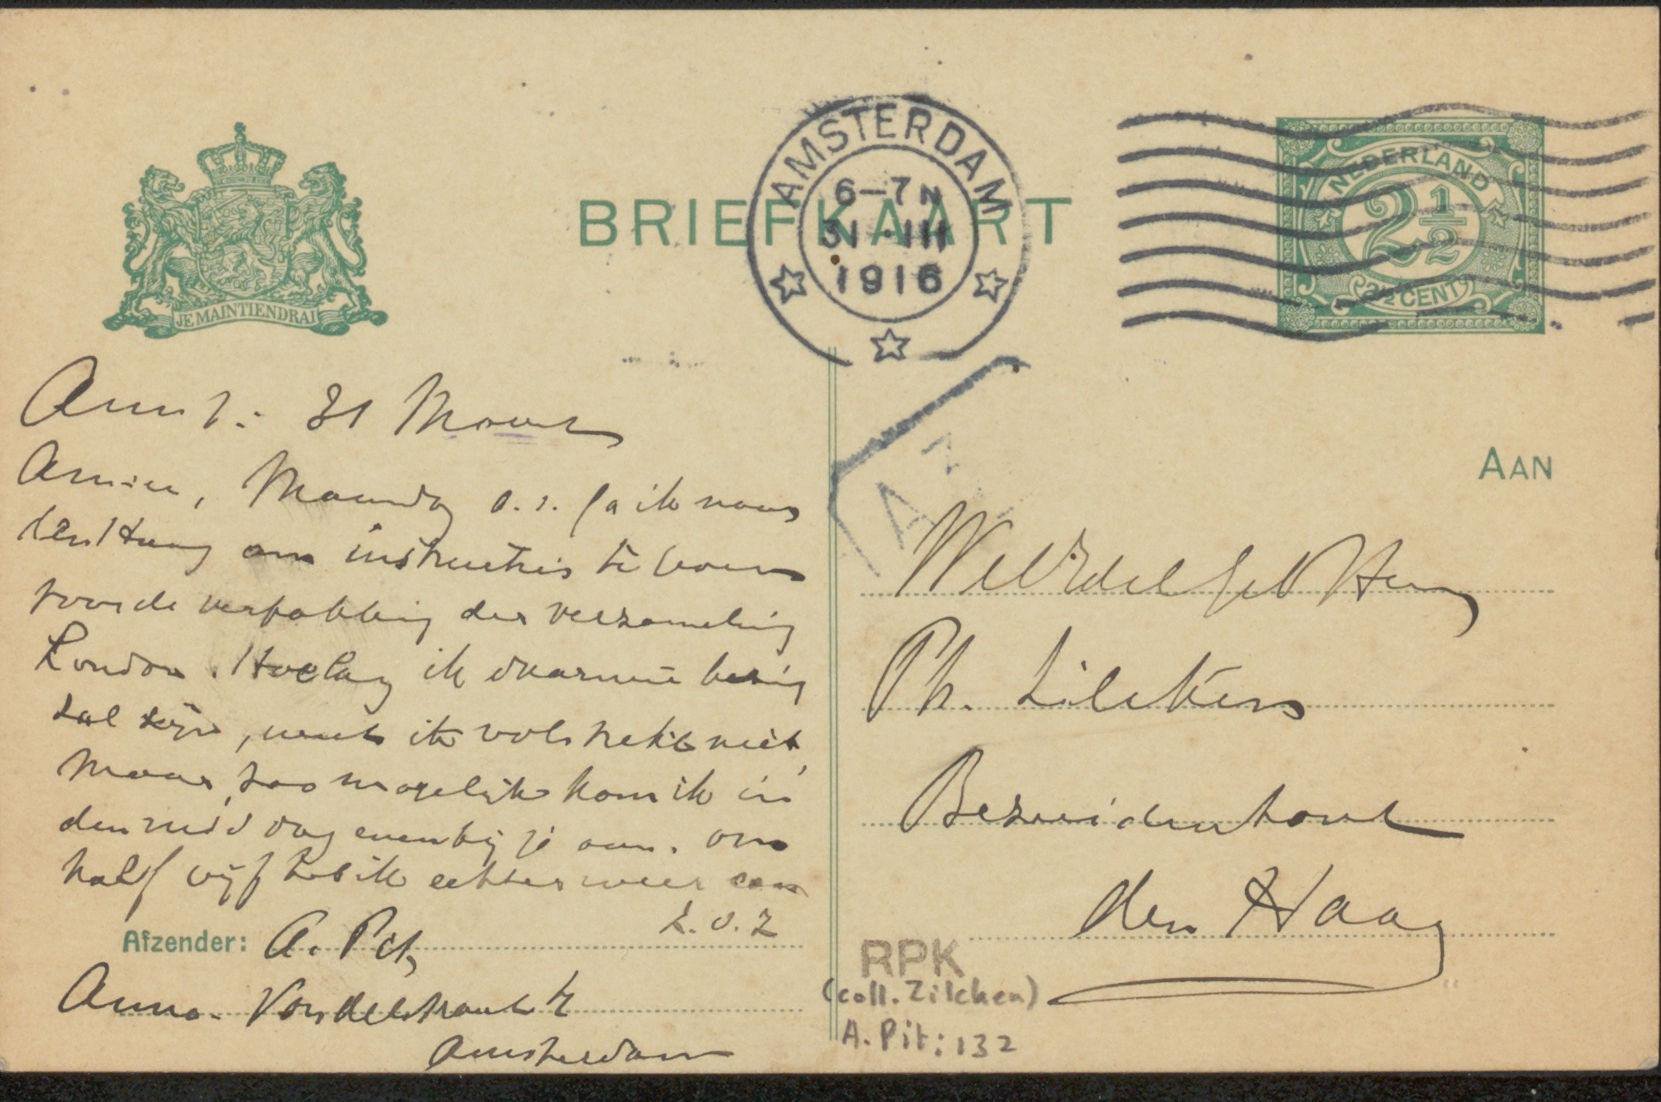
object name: postcard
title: Briefkaart aan Philip Zilcken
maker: adriaan pit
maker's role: print maker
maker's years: 1860-1944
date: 1916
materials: cardboard, ink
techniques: pen, writing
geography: amsterdam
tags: jonkheer john francis loudon, painter, draughtsman, philip zilcken, art collecting, the hague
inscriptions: collector's mark: ‘RPK’